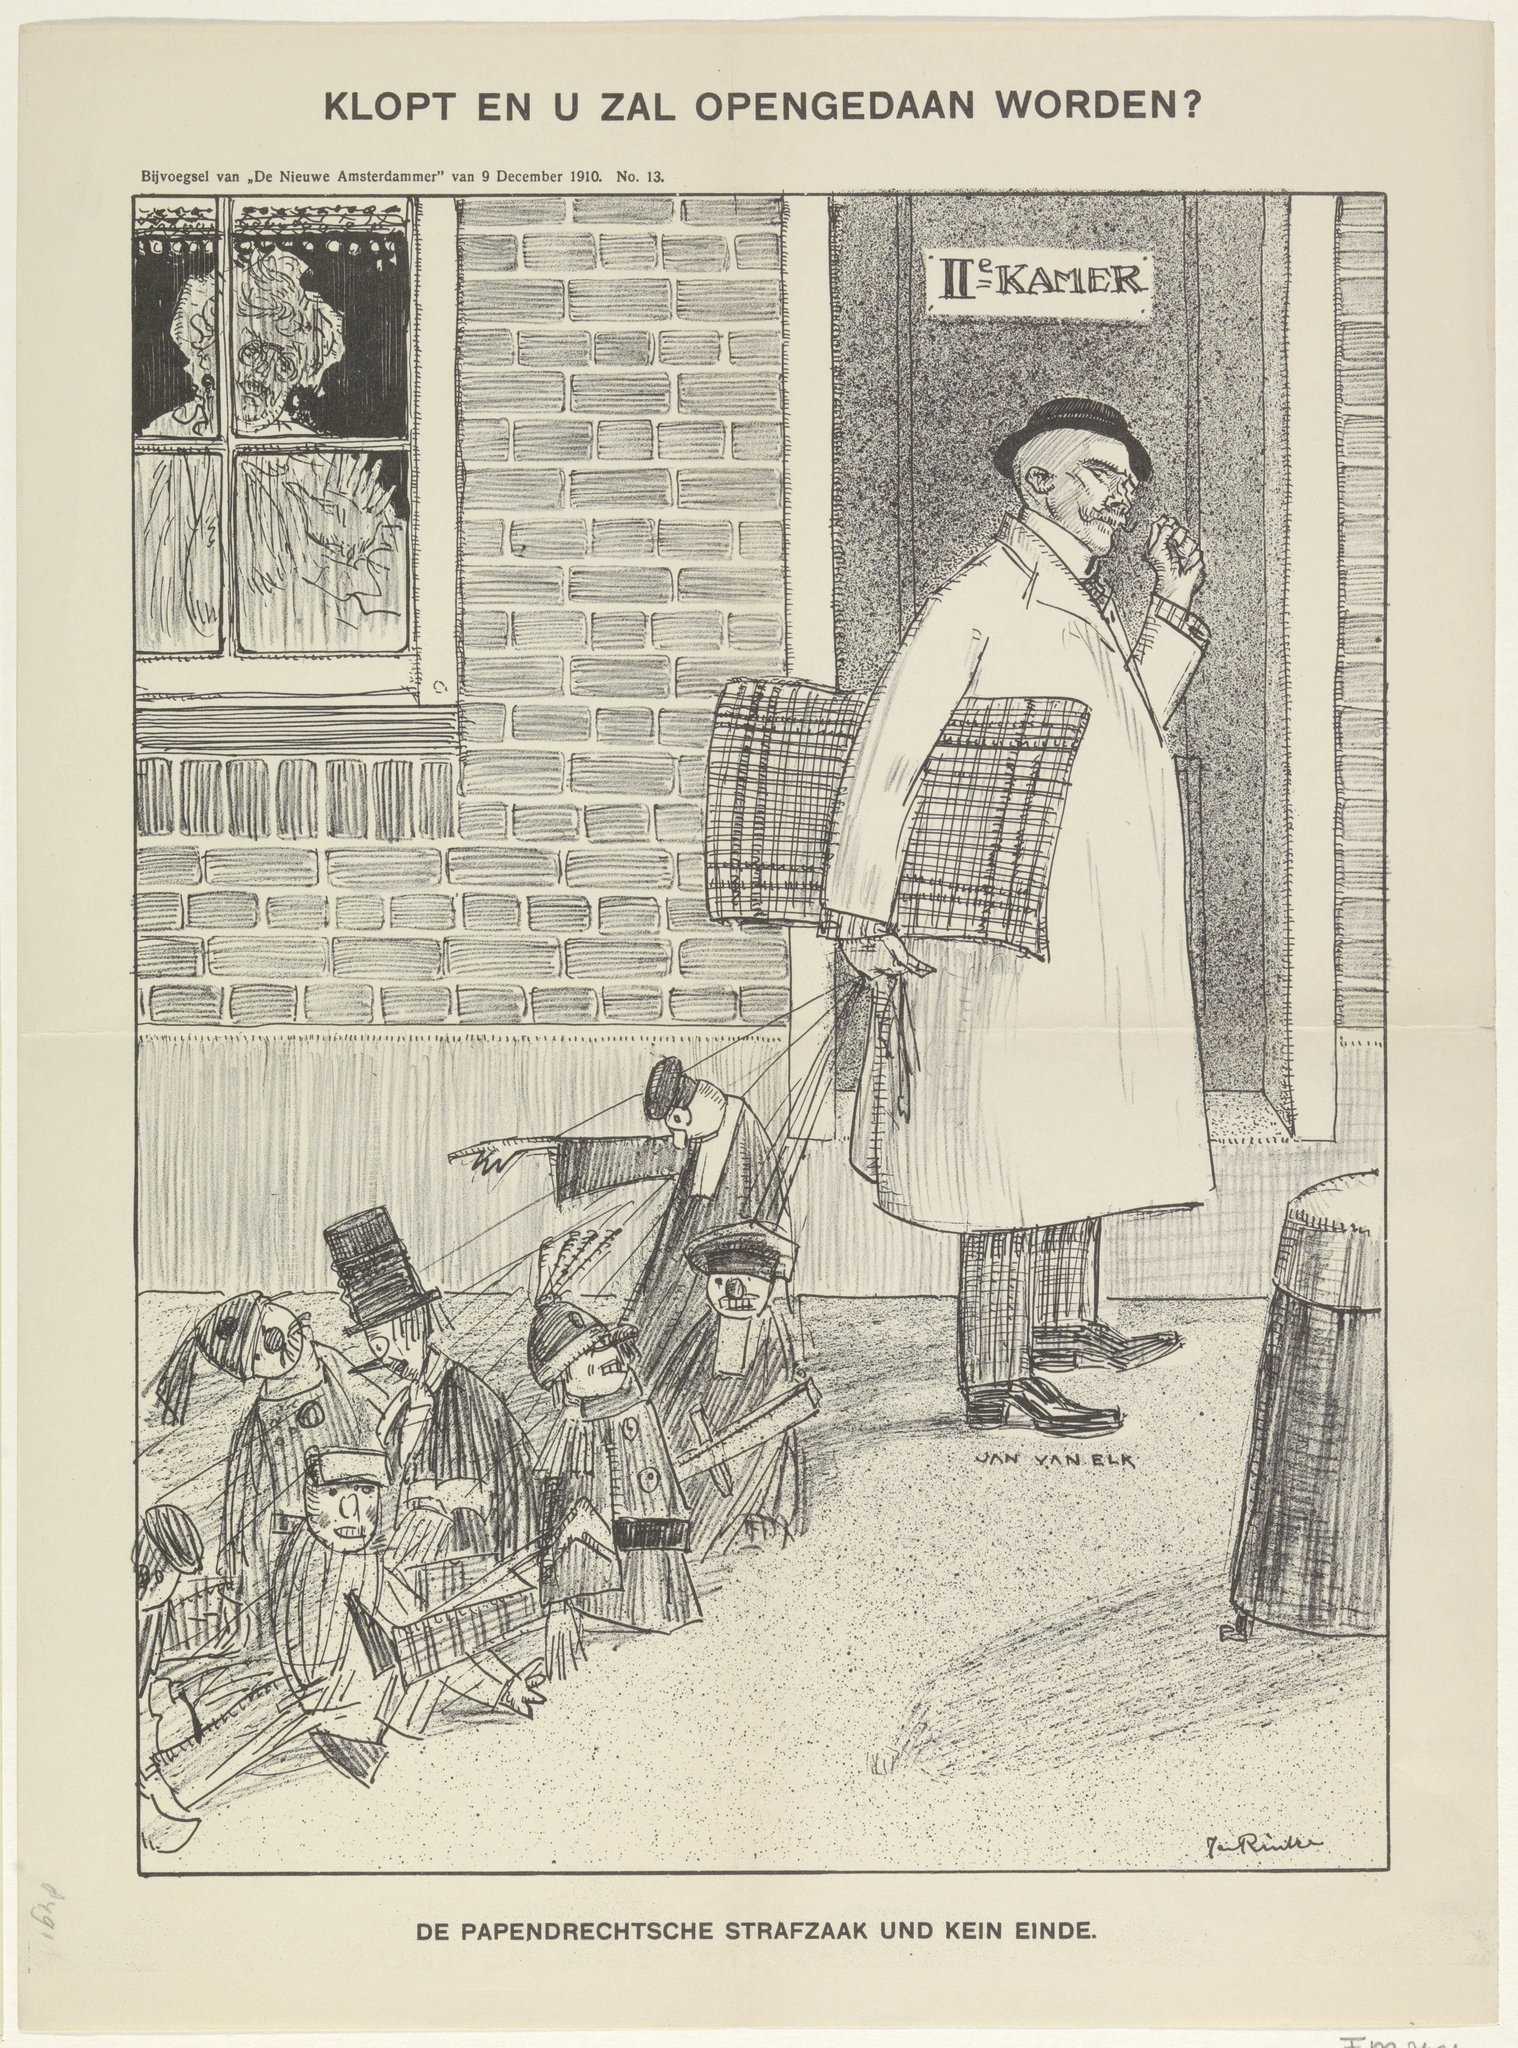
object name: print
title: Klopt en u zal opengedaan worden? / De Papendrechtsche strafzaak und kein einde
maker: jan rinke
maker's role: painter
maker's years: 1863-1922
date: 1910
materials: paper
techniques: lithograph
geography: netherlands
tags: puppet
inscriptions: collector's mark: Lugt 2228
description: Spotprent over de Papendrechtse strafzaak. Jan van Elk trekt achter zich aan een groep poppen van rechters en agenten en klopt op de deur van de Tweede Kamer. Verschenen als bijvoegsel van de Nieuwe Amsterdammer van 9 december 1910, no. 13.